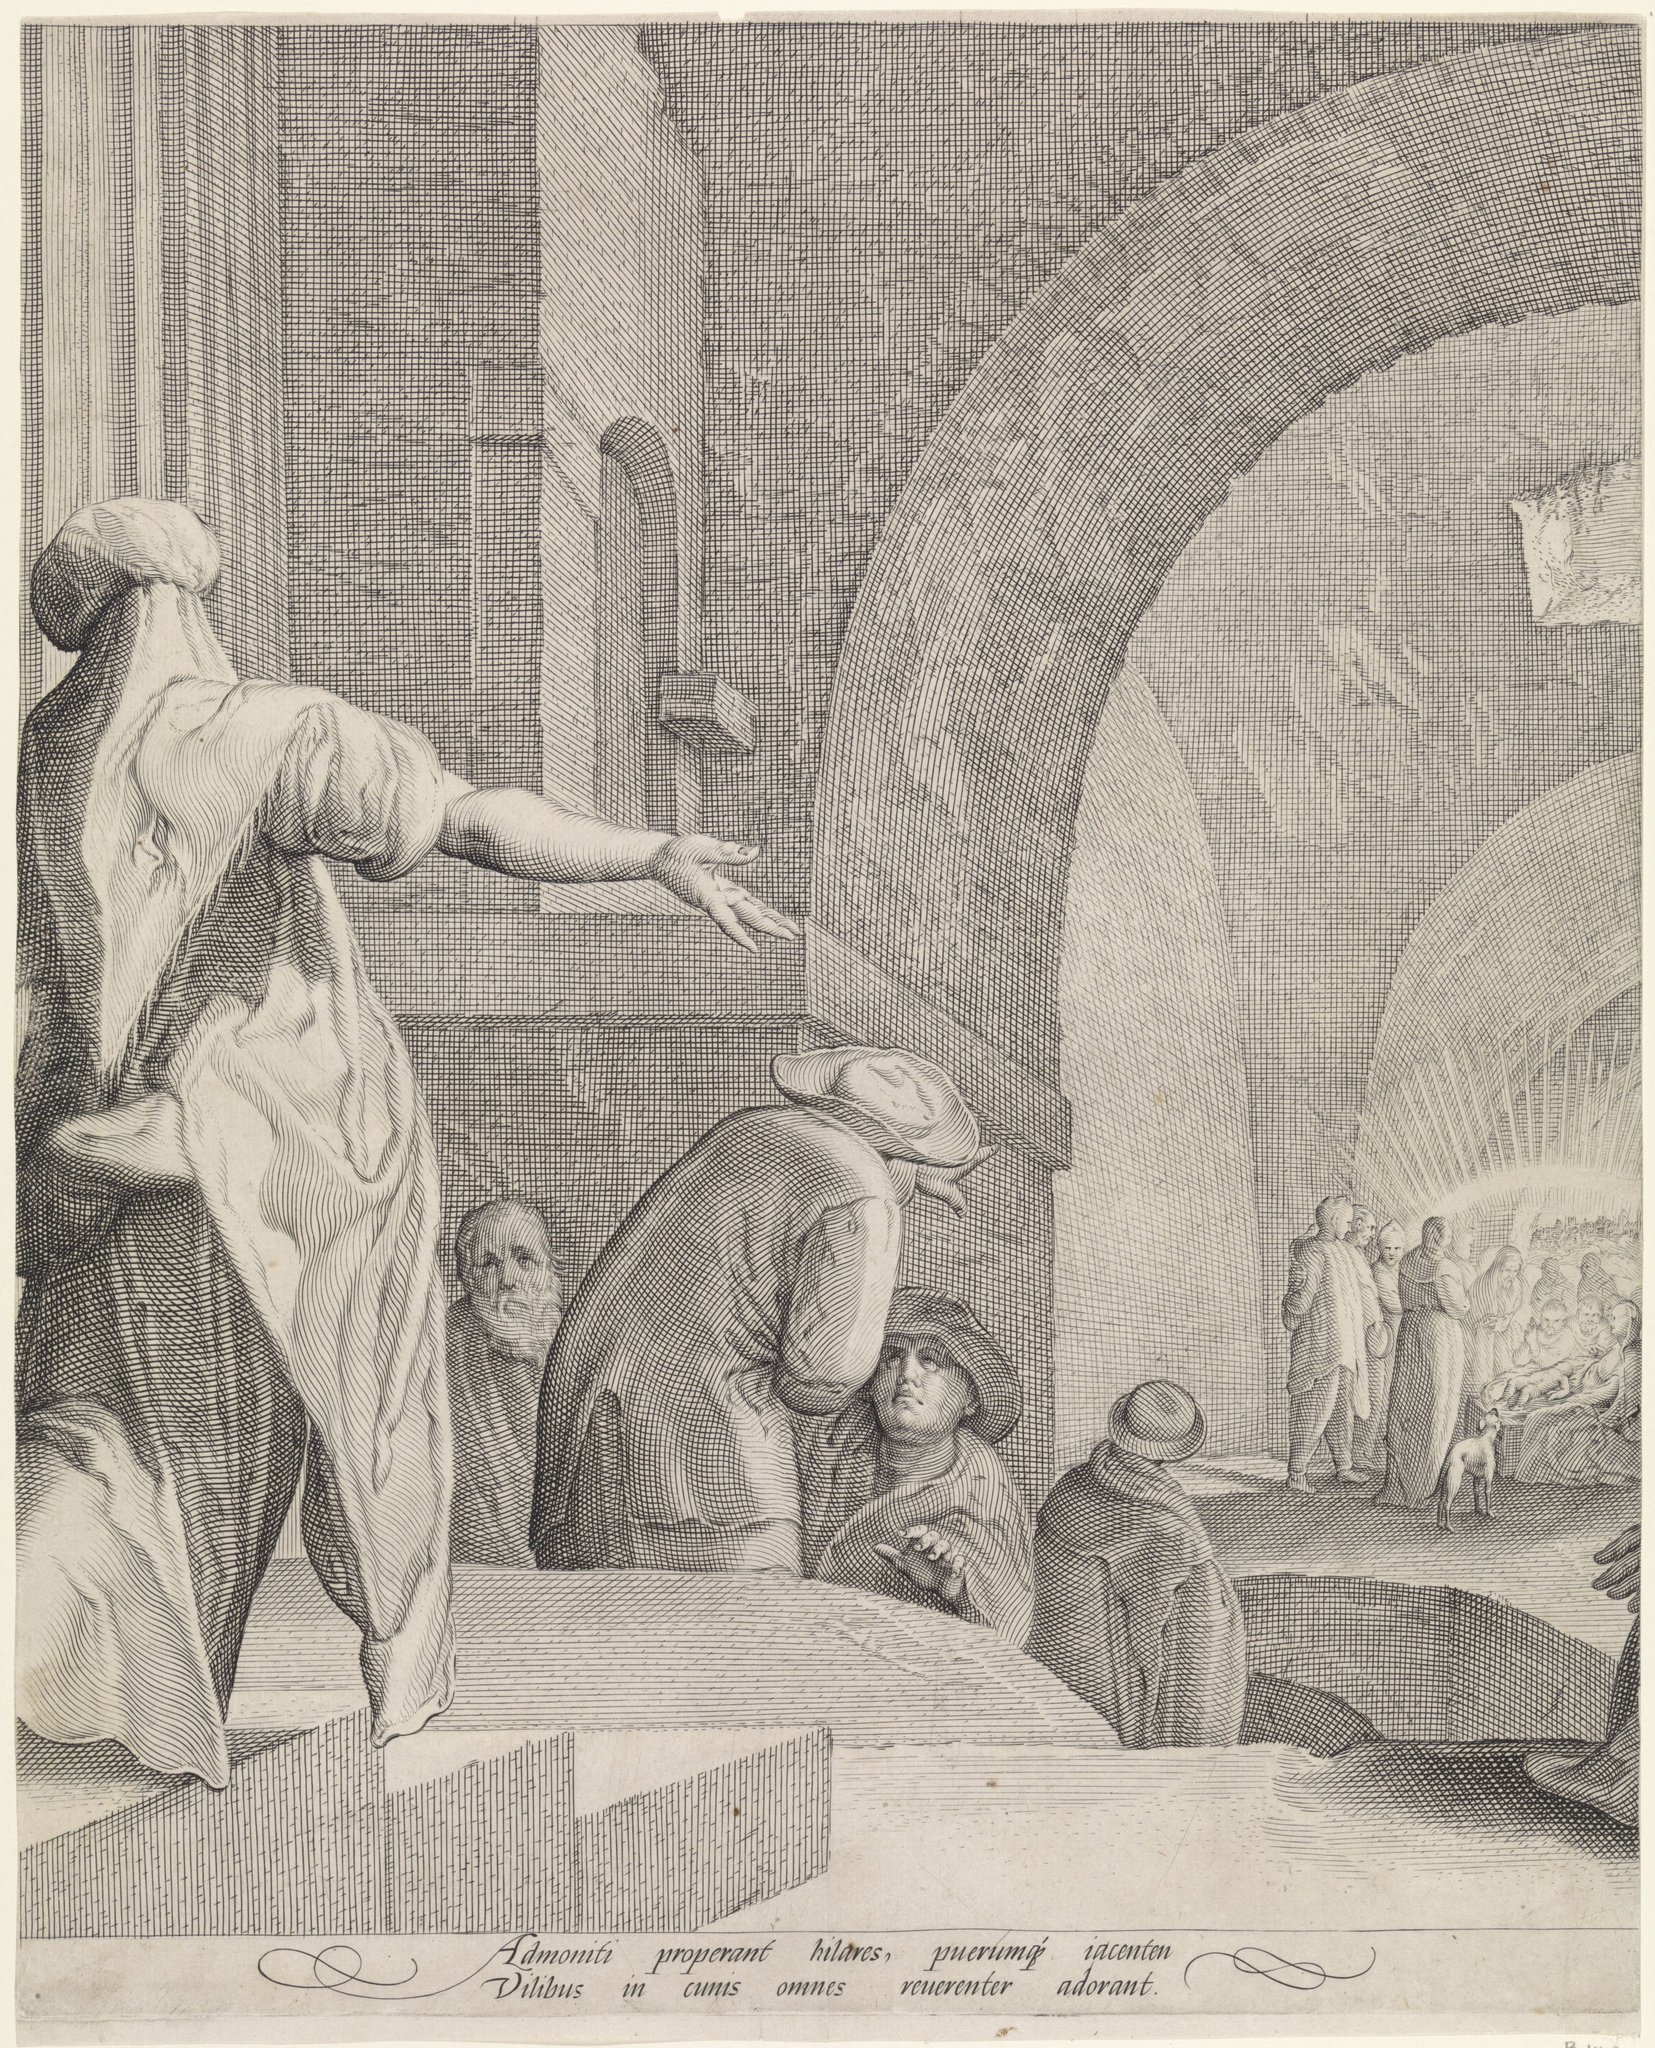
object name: print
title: Aanbidding door de herders (middelste blad)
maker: jan saenredam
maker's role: draughtsman, print maker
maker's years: 1565-1607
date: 1589-1607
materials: paper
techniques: engraving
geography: amsterdam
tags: adoration of the christ-child by the shepherds; mary and joseph present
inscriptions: collector's mark: Lugt 240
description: Vooraan enkele herders in een gewelfde ruimte. Rechts in de verte nog enkele herders rond Jozef en Maria met het Christuskind. Onder de voorstelling een tweeregelige, Latijnse tekst met een toelichting op de aanbiddingsscène.